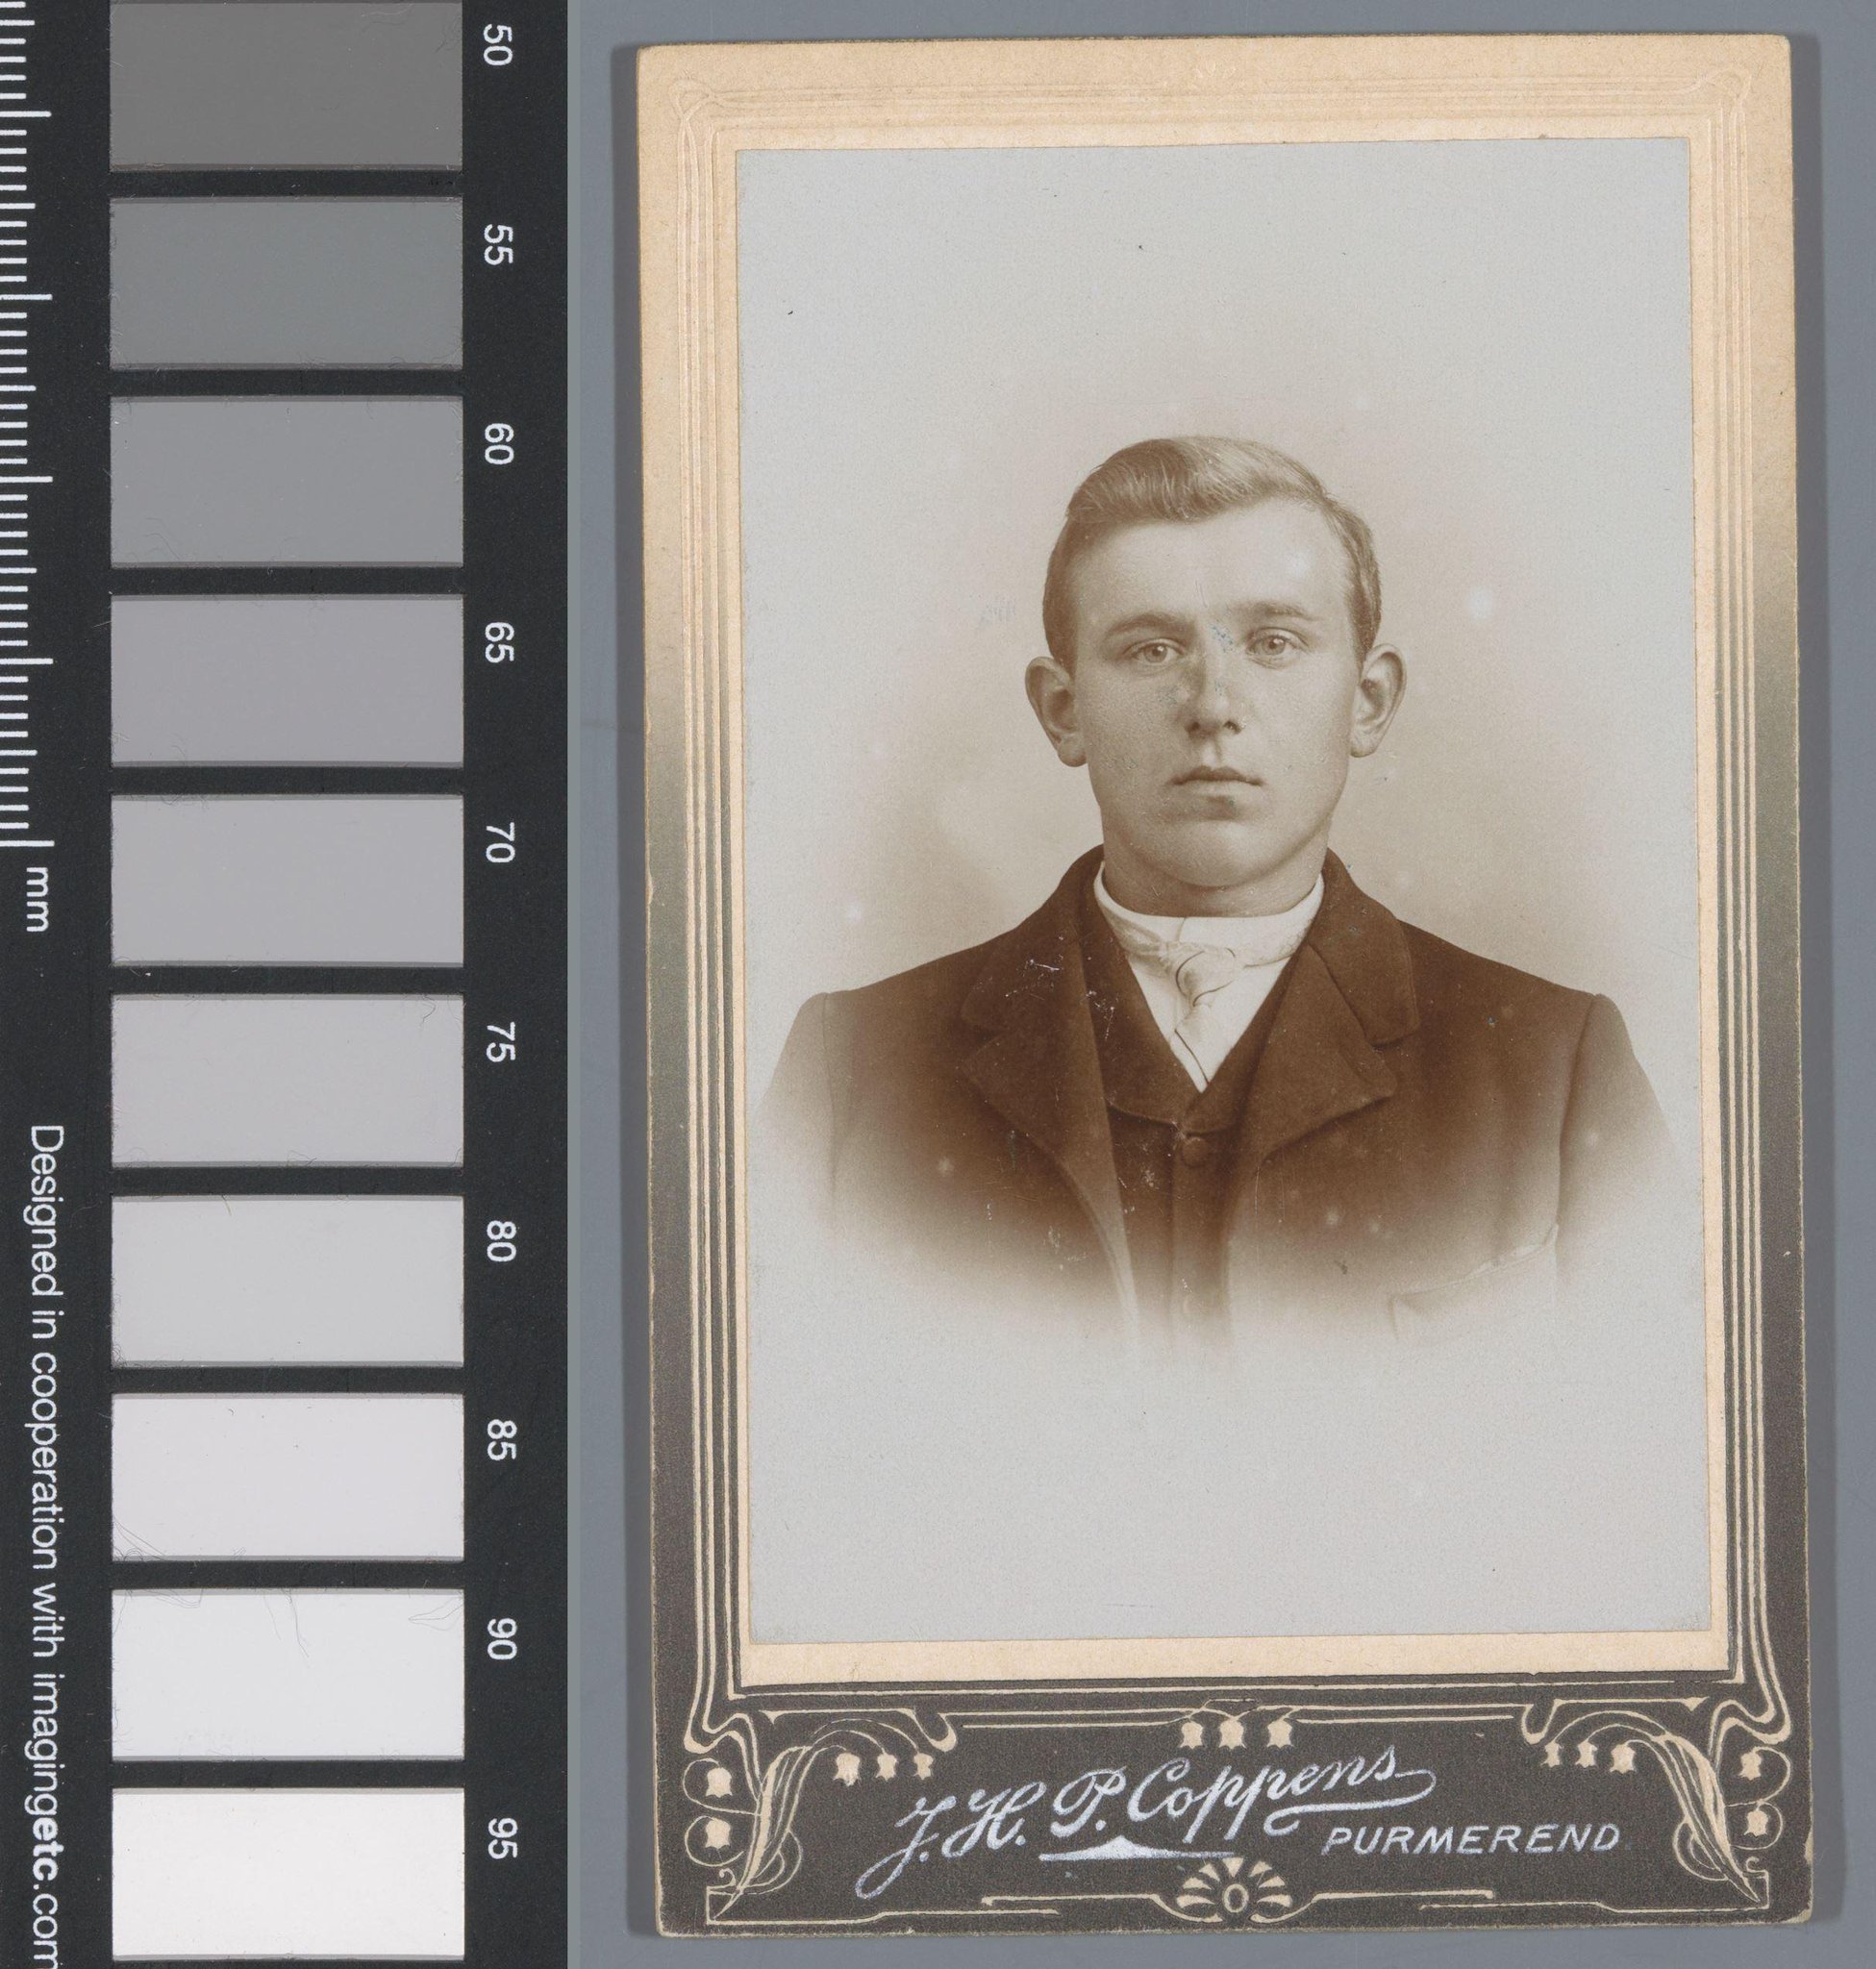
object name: photograph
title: Portret van Piet Heijn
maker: josephus hendrikus petrus coppens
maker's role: fotograaf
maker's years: 1864-1941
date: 1889-1925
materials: cardboard, photographic support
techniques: collodion silver print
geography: purmerend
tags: adult man, historical persons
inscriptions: inscription: ‘Piet Heijn’